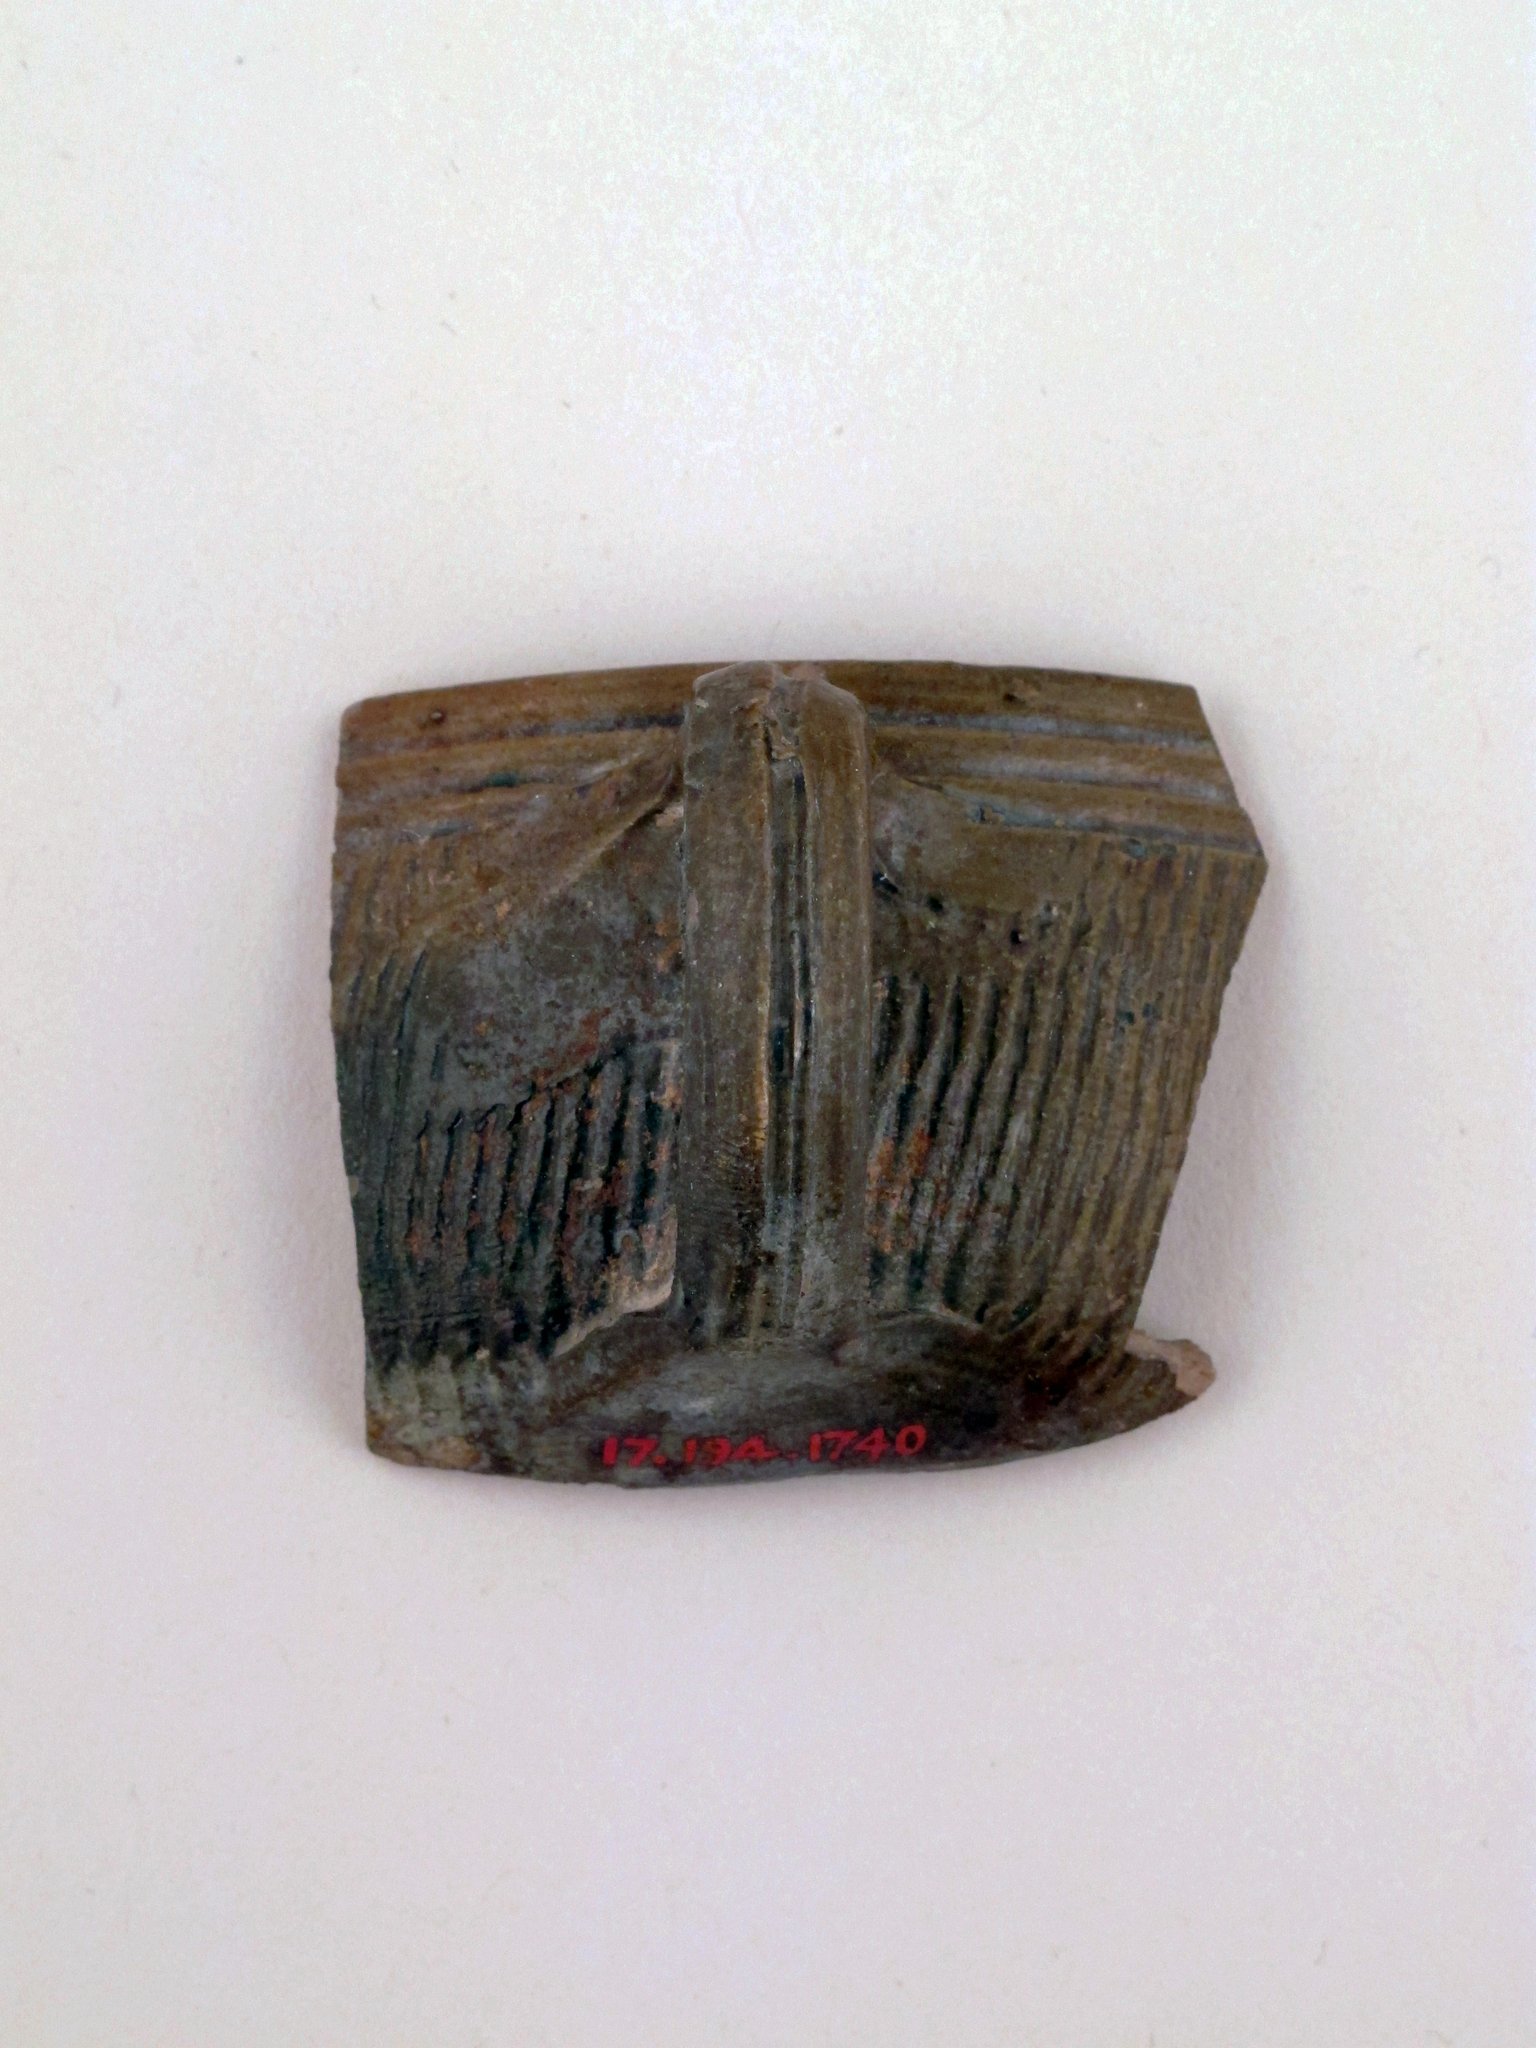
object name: vase fragment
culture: roman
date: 670 BCE-330 CE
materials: terracotta